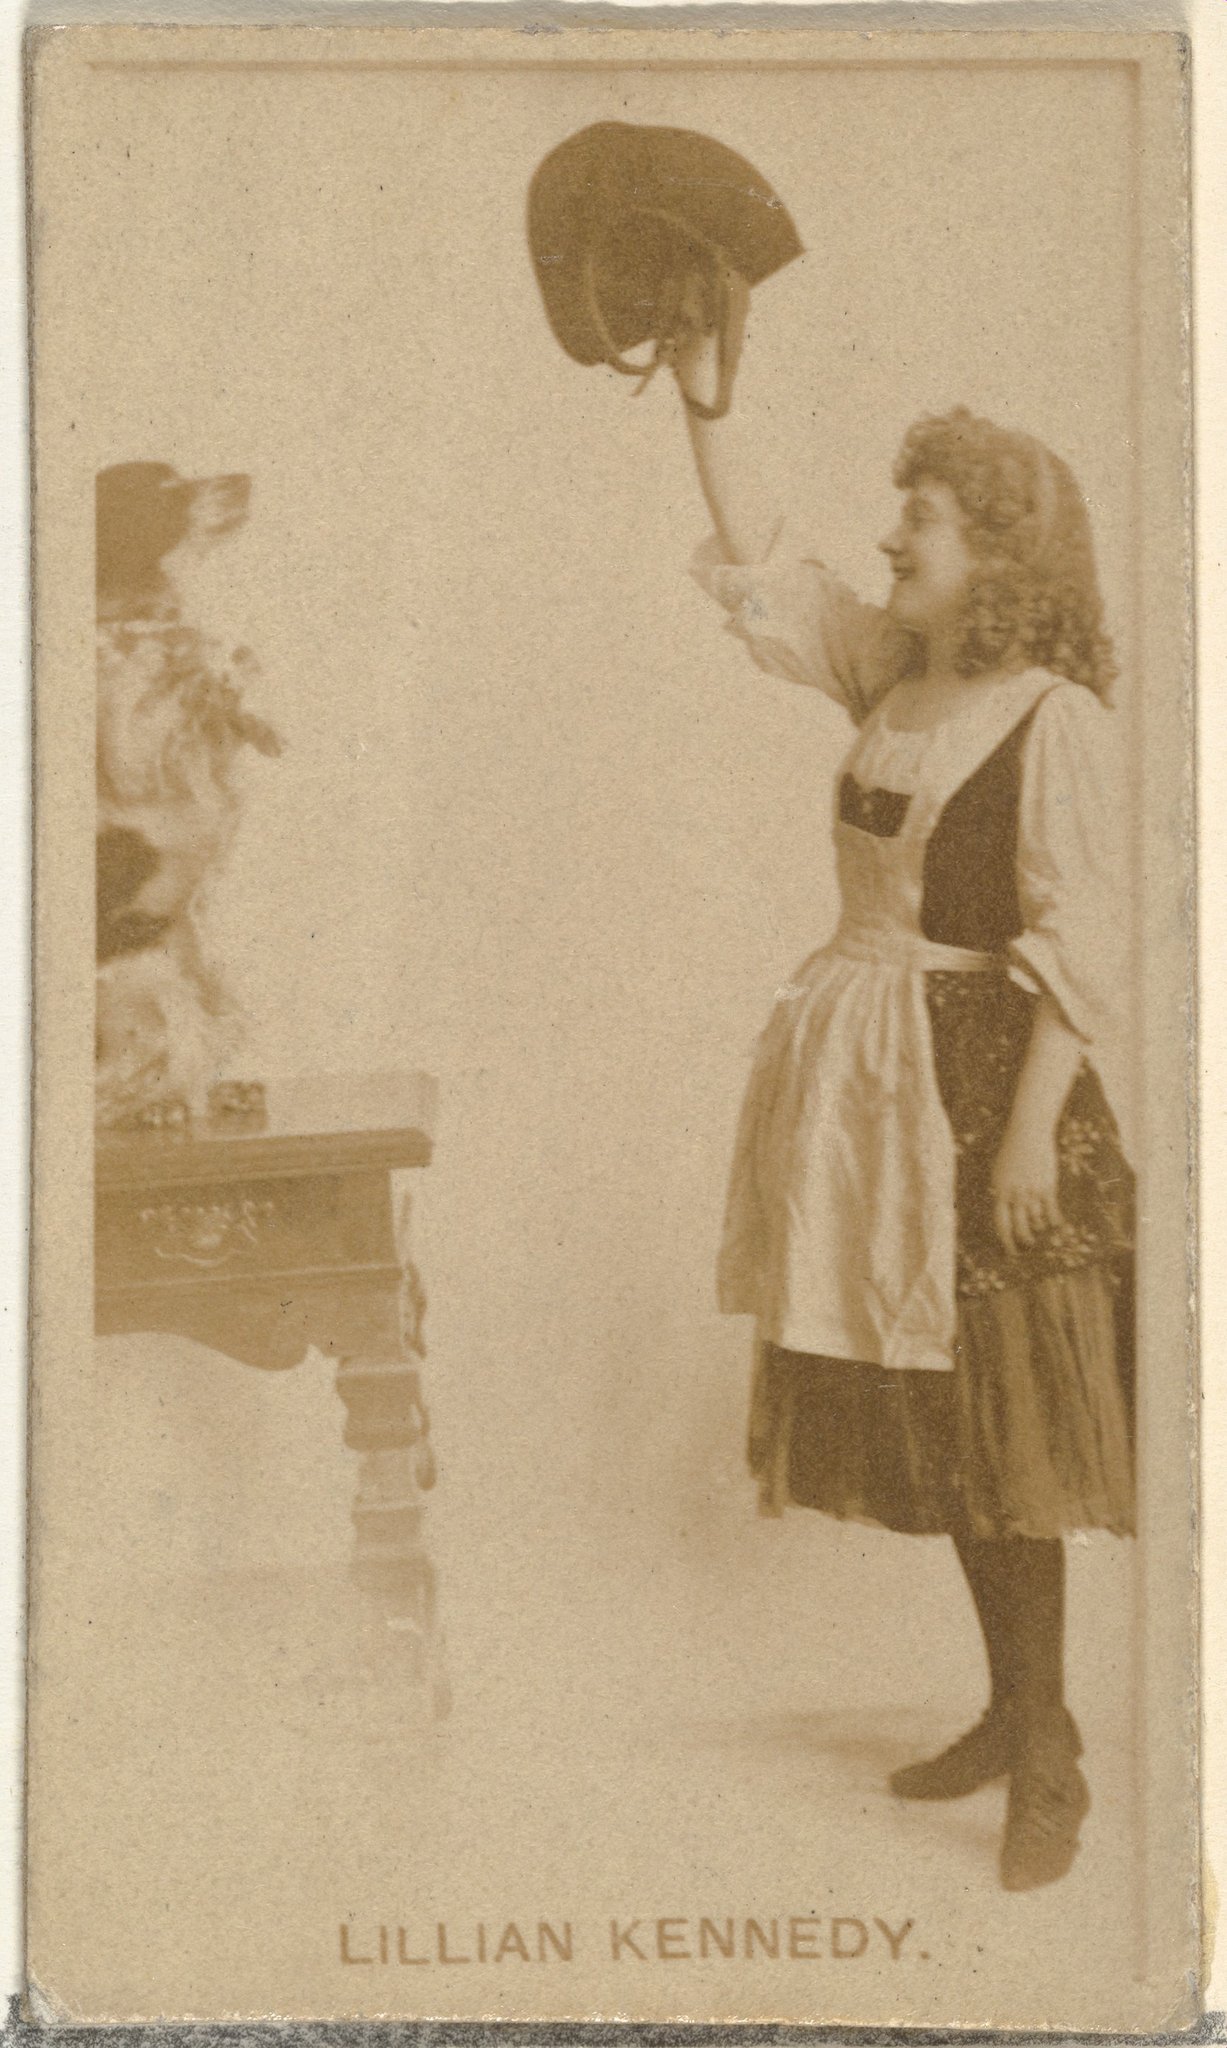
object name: photograph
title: Lillian Kennedy, from the Actors and Actresses series (N145-8) issued by Duke Sons & Co. to promote Duke Cigarettes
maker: w. duke, sons & co.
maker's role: publisher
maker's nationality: american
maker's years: 1870-1920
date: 1891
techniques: albumen silver print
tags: portraits,women,actresses